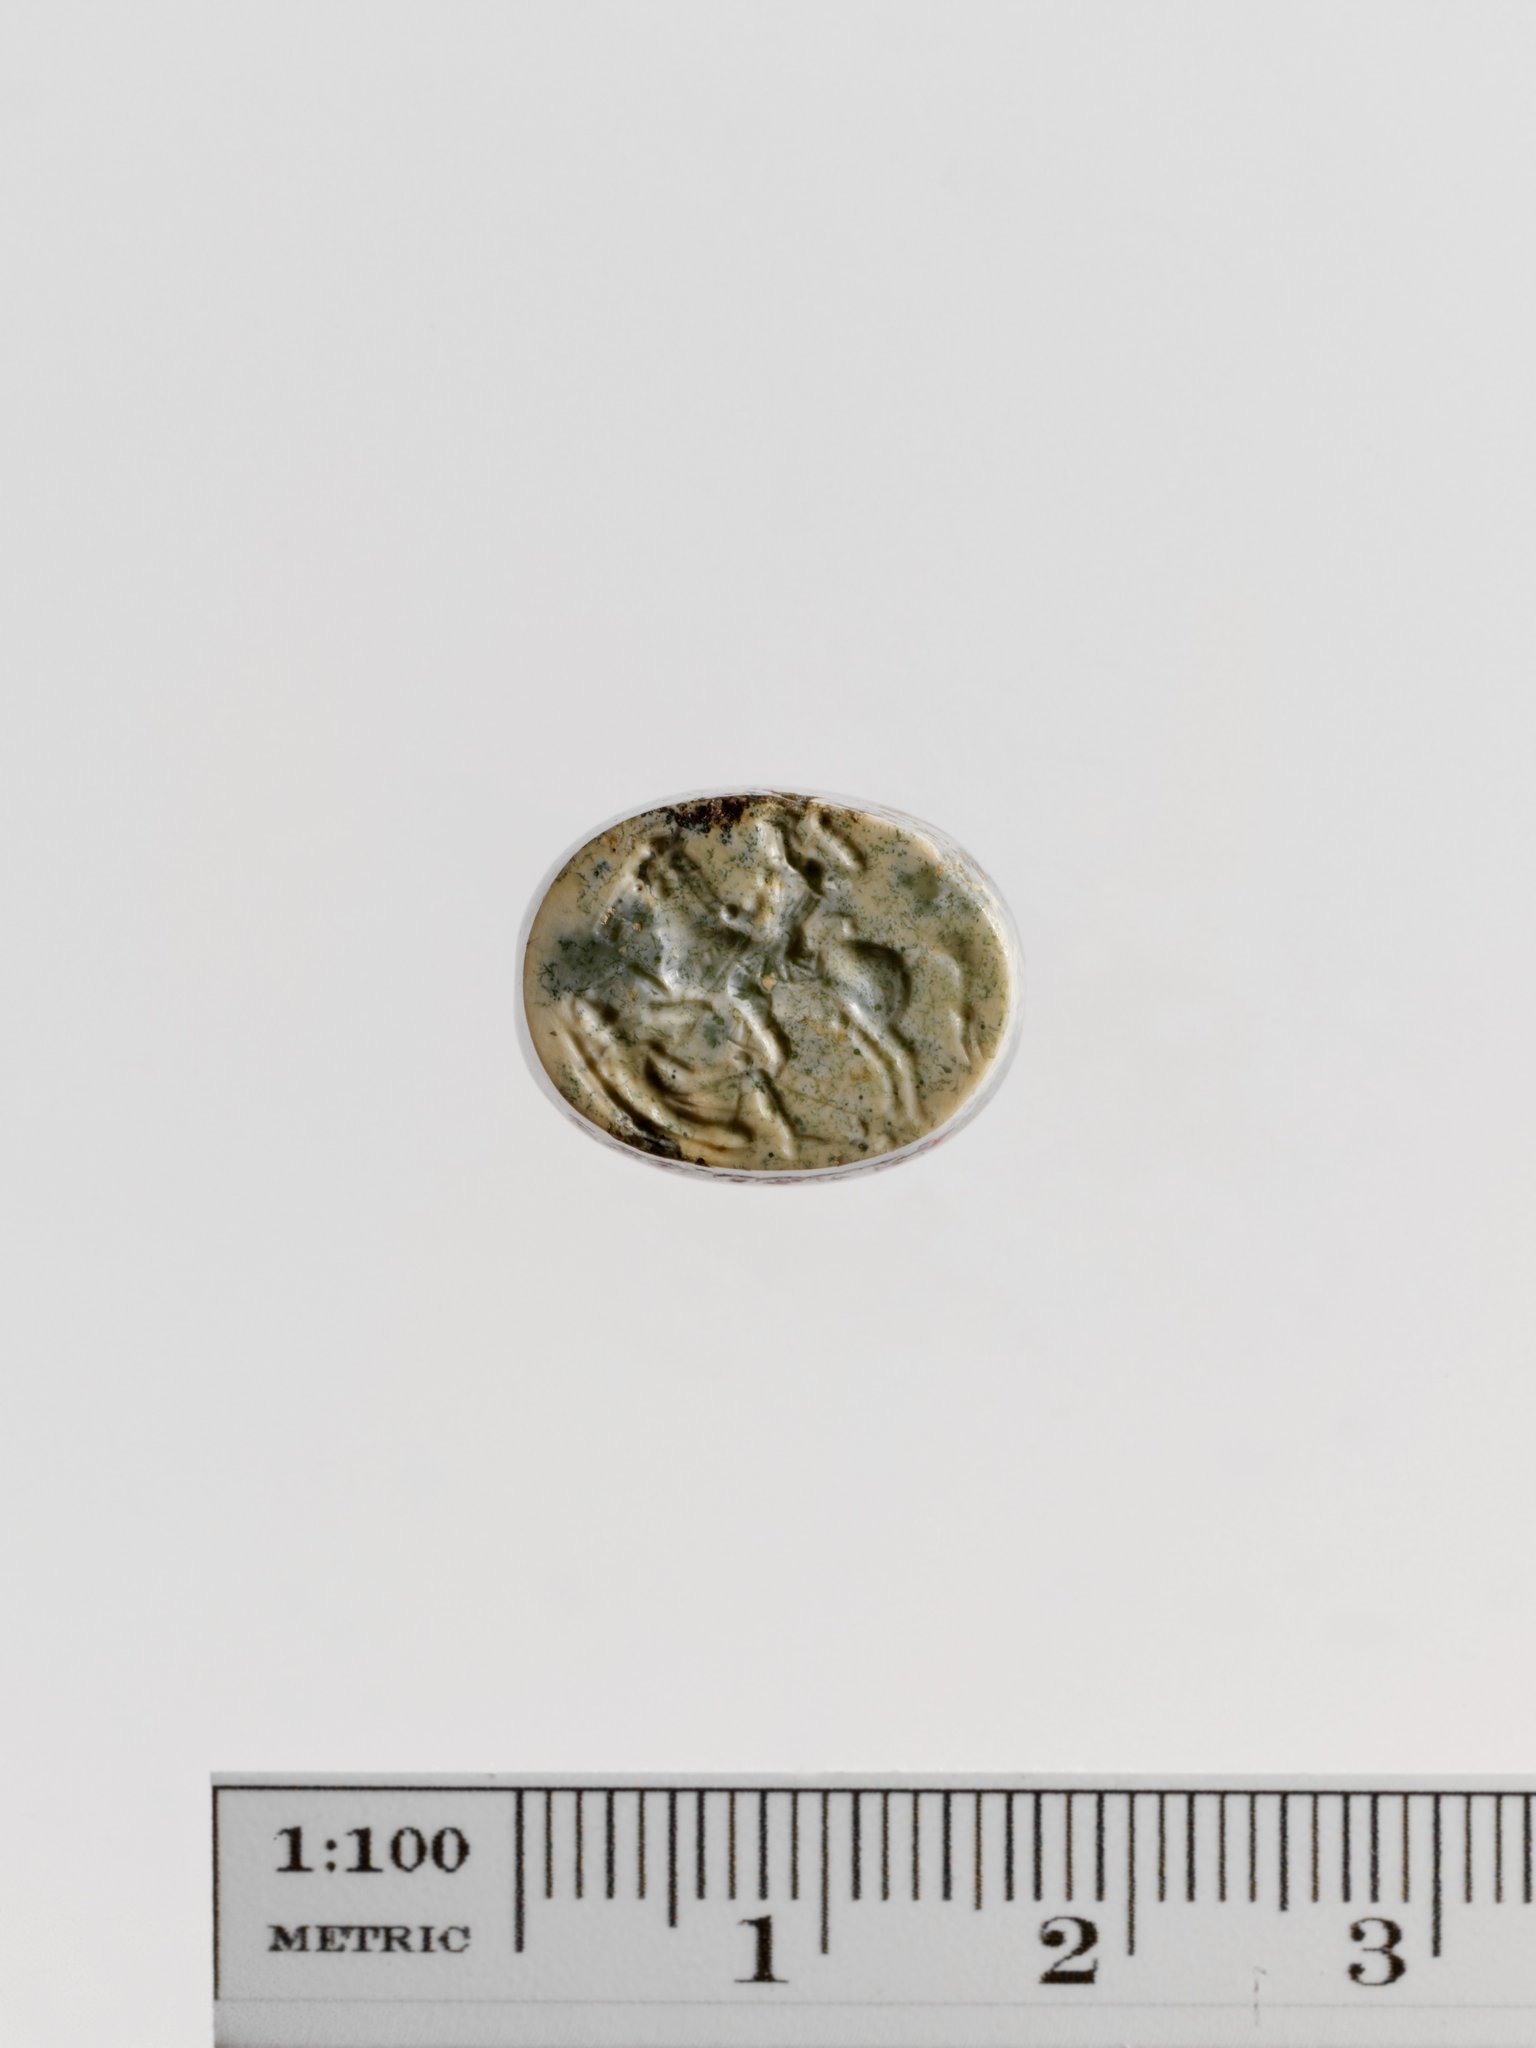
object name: scaraboid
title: Plasma scaraboid seal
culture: greek, ionian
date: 450-400 BCE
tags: men,horses